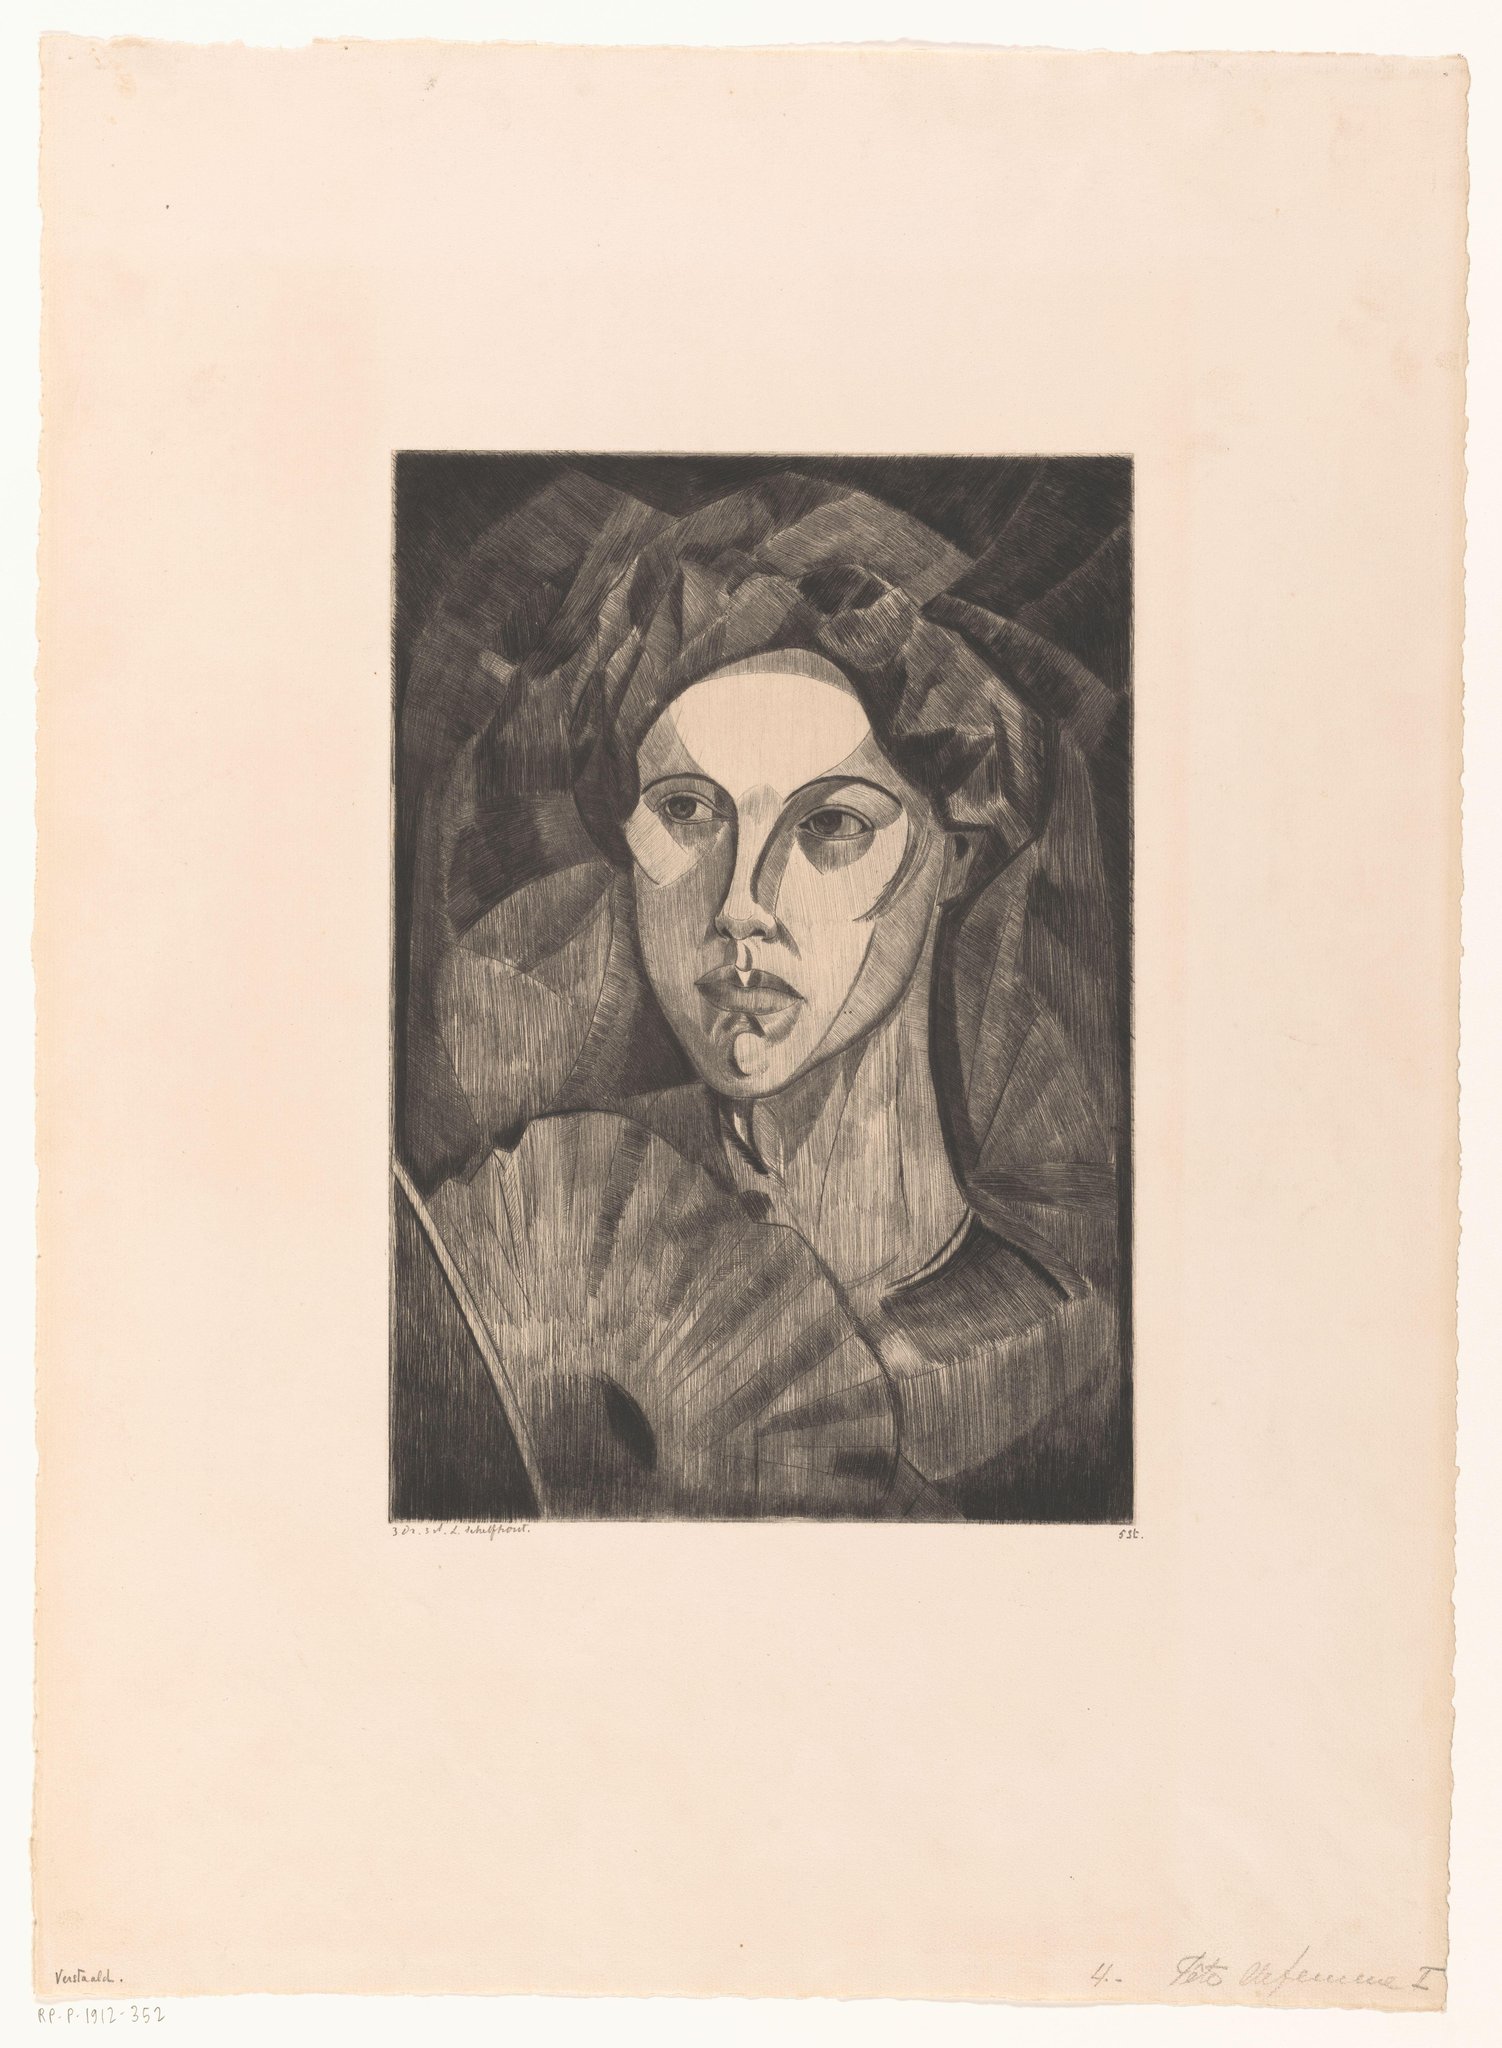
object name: print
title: Hoofd van een vrouw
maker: lodewijk schelfhout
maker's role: draughtsman, print maker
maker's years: 1881-1943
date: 1912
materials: paper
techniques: drypoint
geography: paris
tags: fan, head (human) - aa - female human figure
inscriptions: collector's mark: Lugt 2228